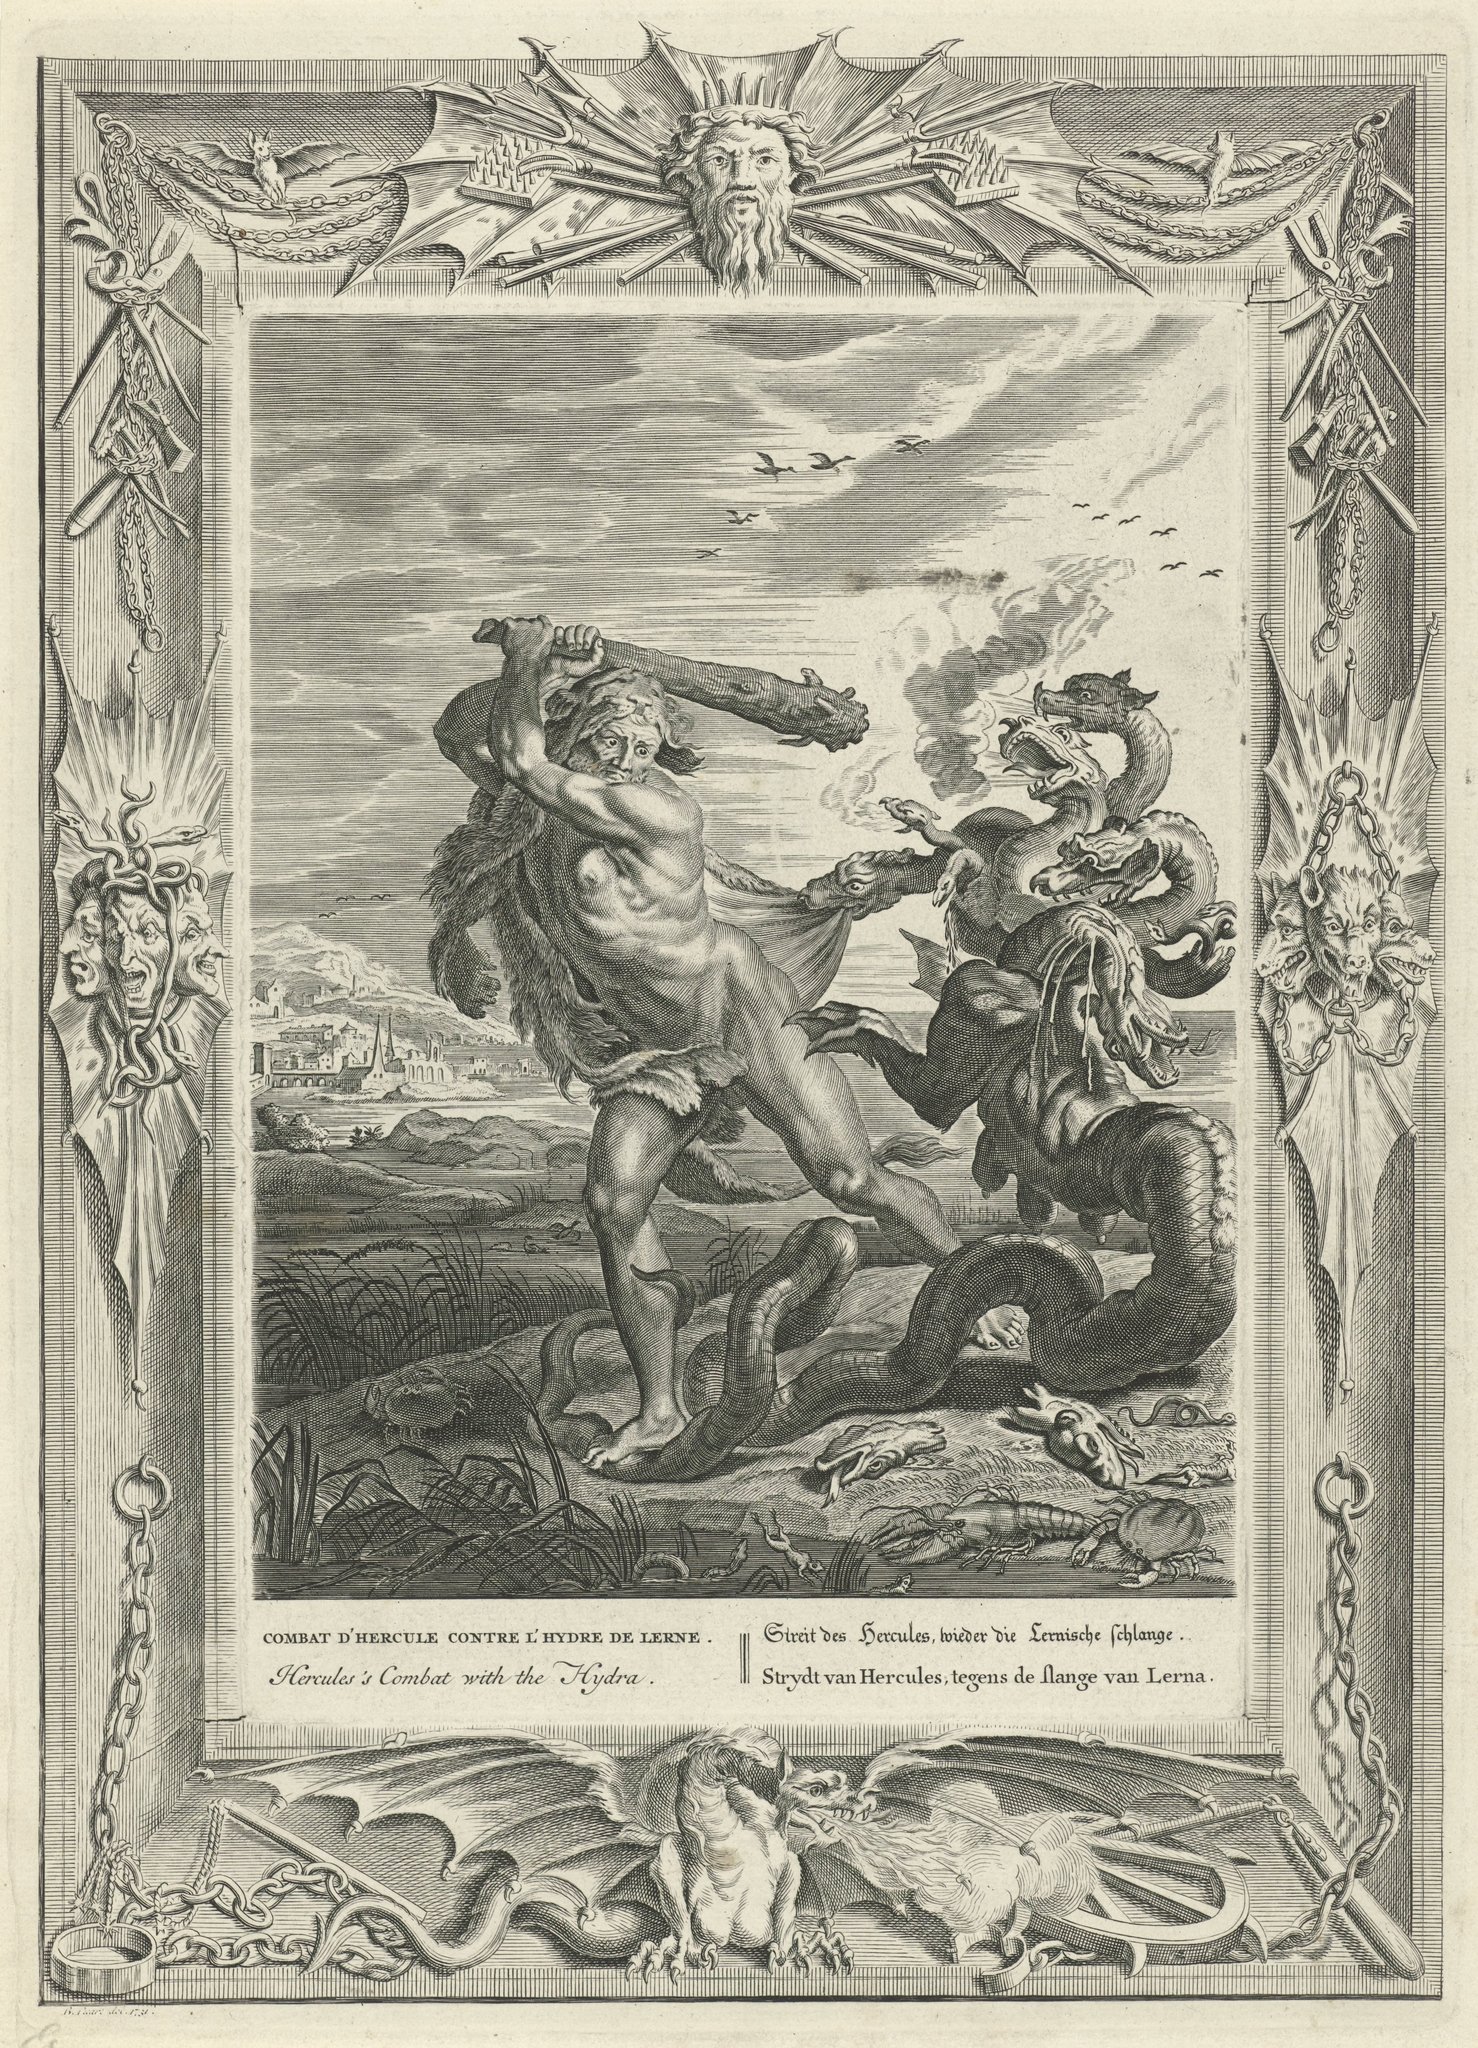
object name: print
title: Hercules doodt de hydra van Lerna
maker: bernard picart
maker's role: draughtsman, print maker, publisher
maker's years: 1673-1733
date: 1731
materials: paper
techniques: engraving, etching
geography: amsterdam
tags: scrollwork, strapwork ~ ornament, (2) the hydra of lerna is killed by hercules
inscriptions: collector's mark: Lugt 2228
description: Prent ook als illustratie gebruikt in: Beaumarchais, Antoine de La Barre de. Le Temple des Muses: orné de 60 tableaux où sont représentés les événemens les plus remarquables de l'antiquité fabuleuse. Amsterdam: Zacharias Chatelain (II), 1733.